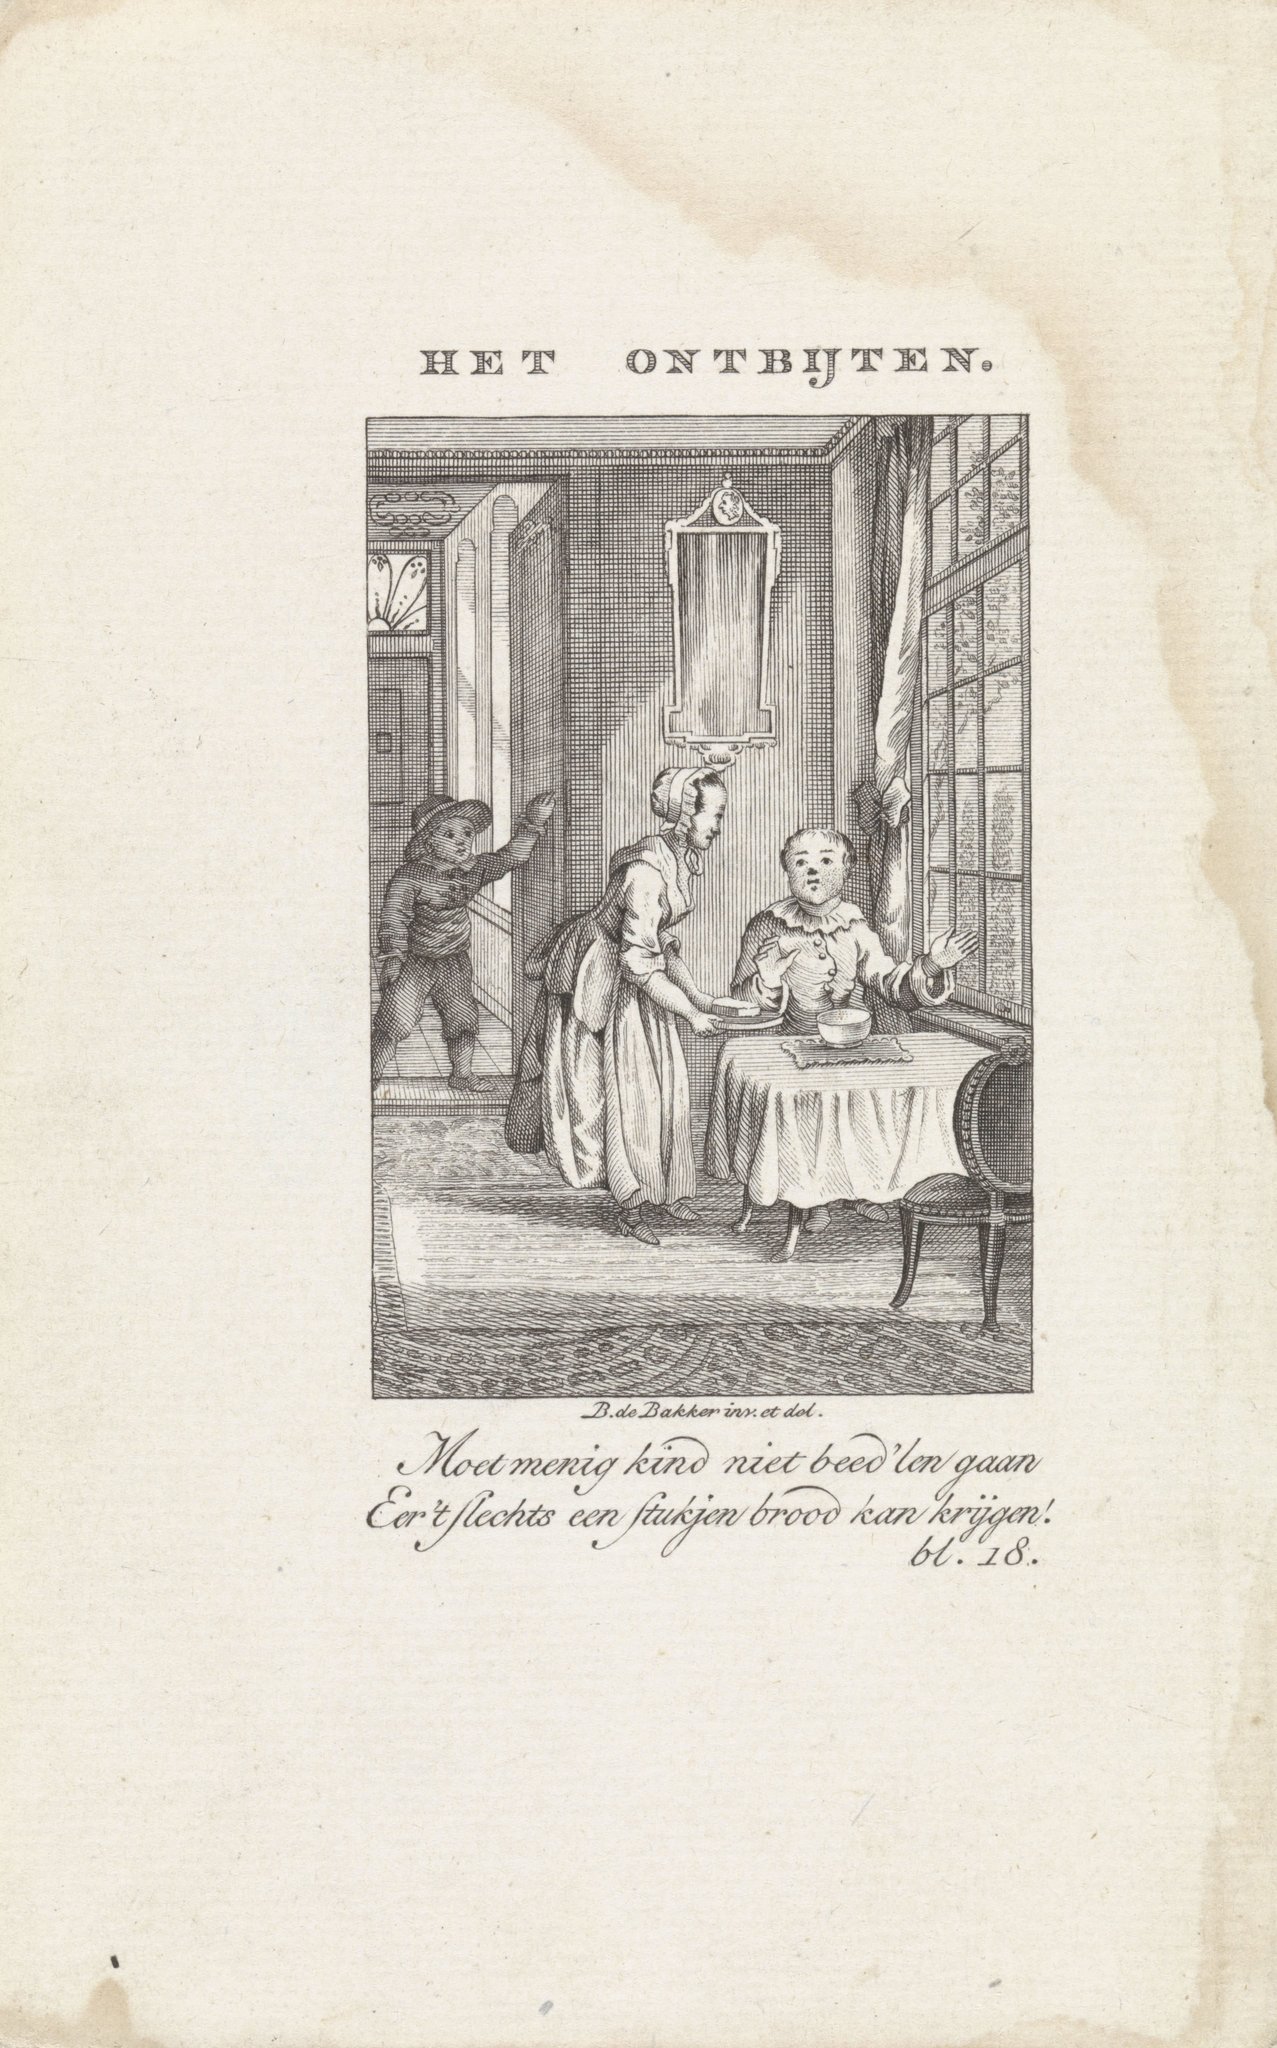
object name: print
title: Het ontbijten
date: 1789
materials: paper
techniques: engraving, etching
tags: breakfast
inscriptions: collector's mark: Lugt 2228, collector's mark: Lugt 2760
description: Prent uit: Hazeu, Johannes Cornelisz., Kinderpligt en zinnebeelden, Willem van Vliet (uitgever), Amsterdam 1789